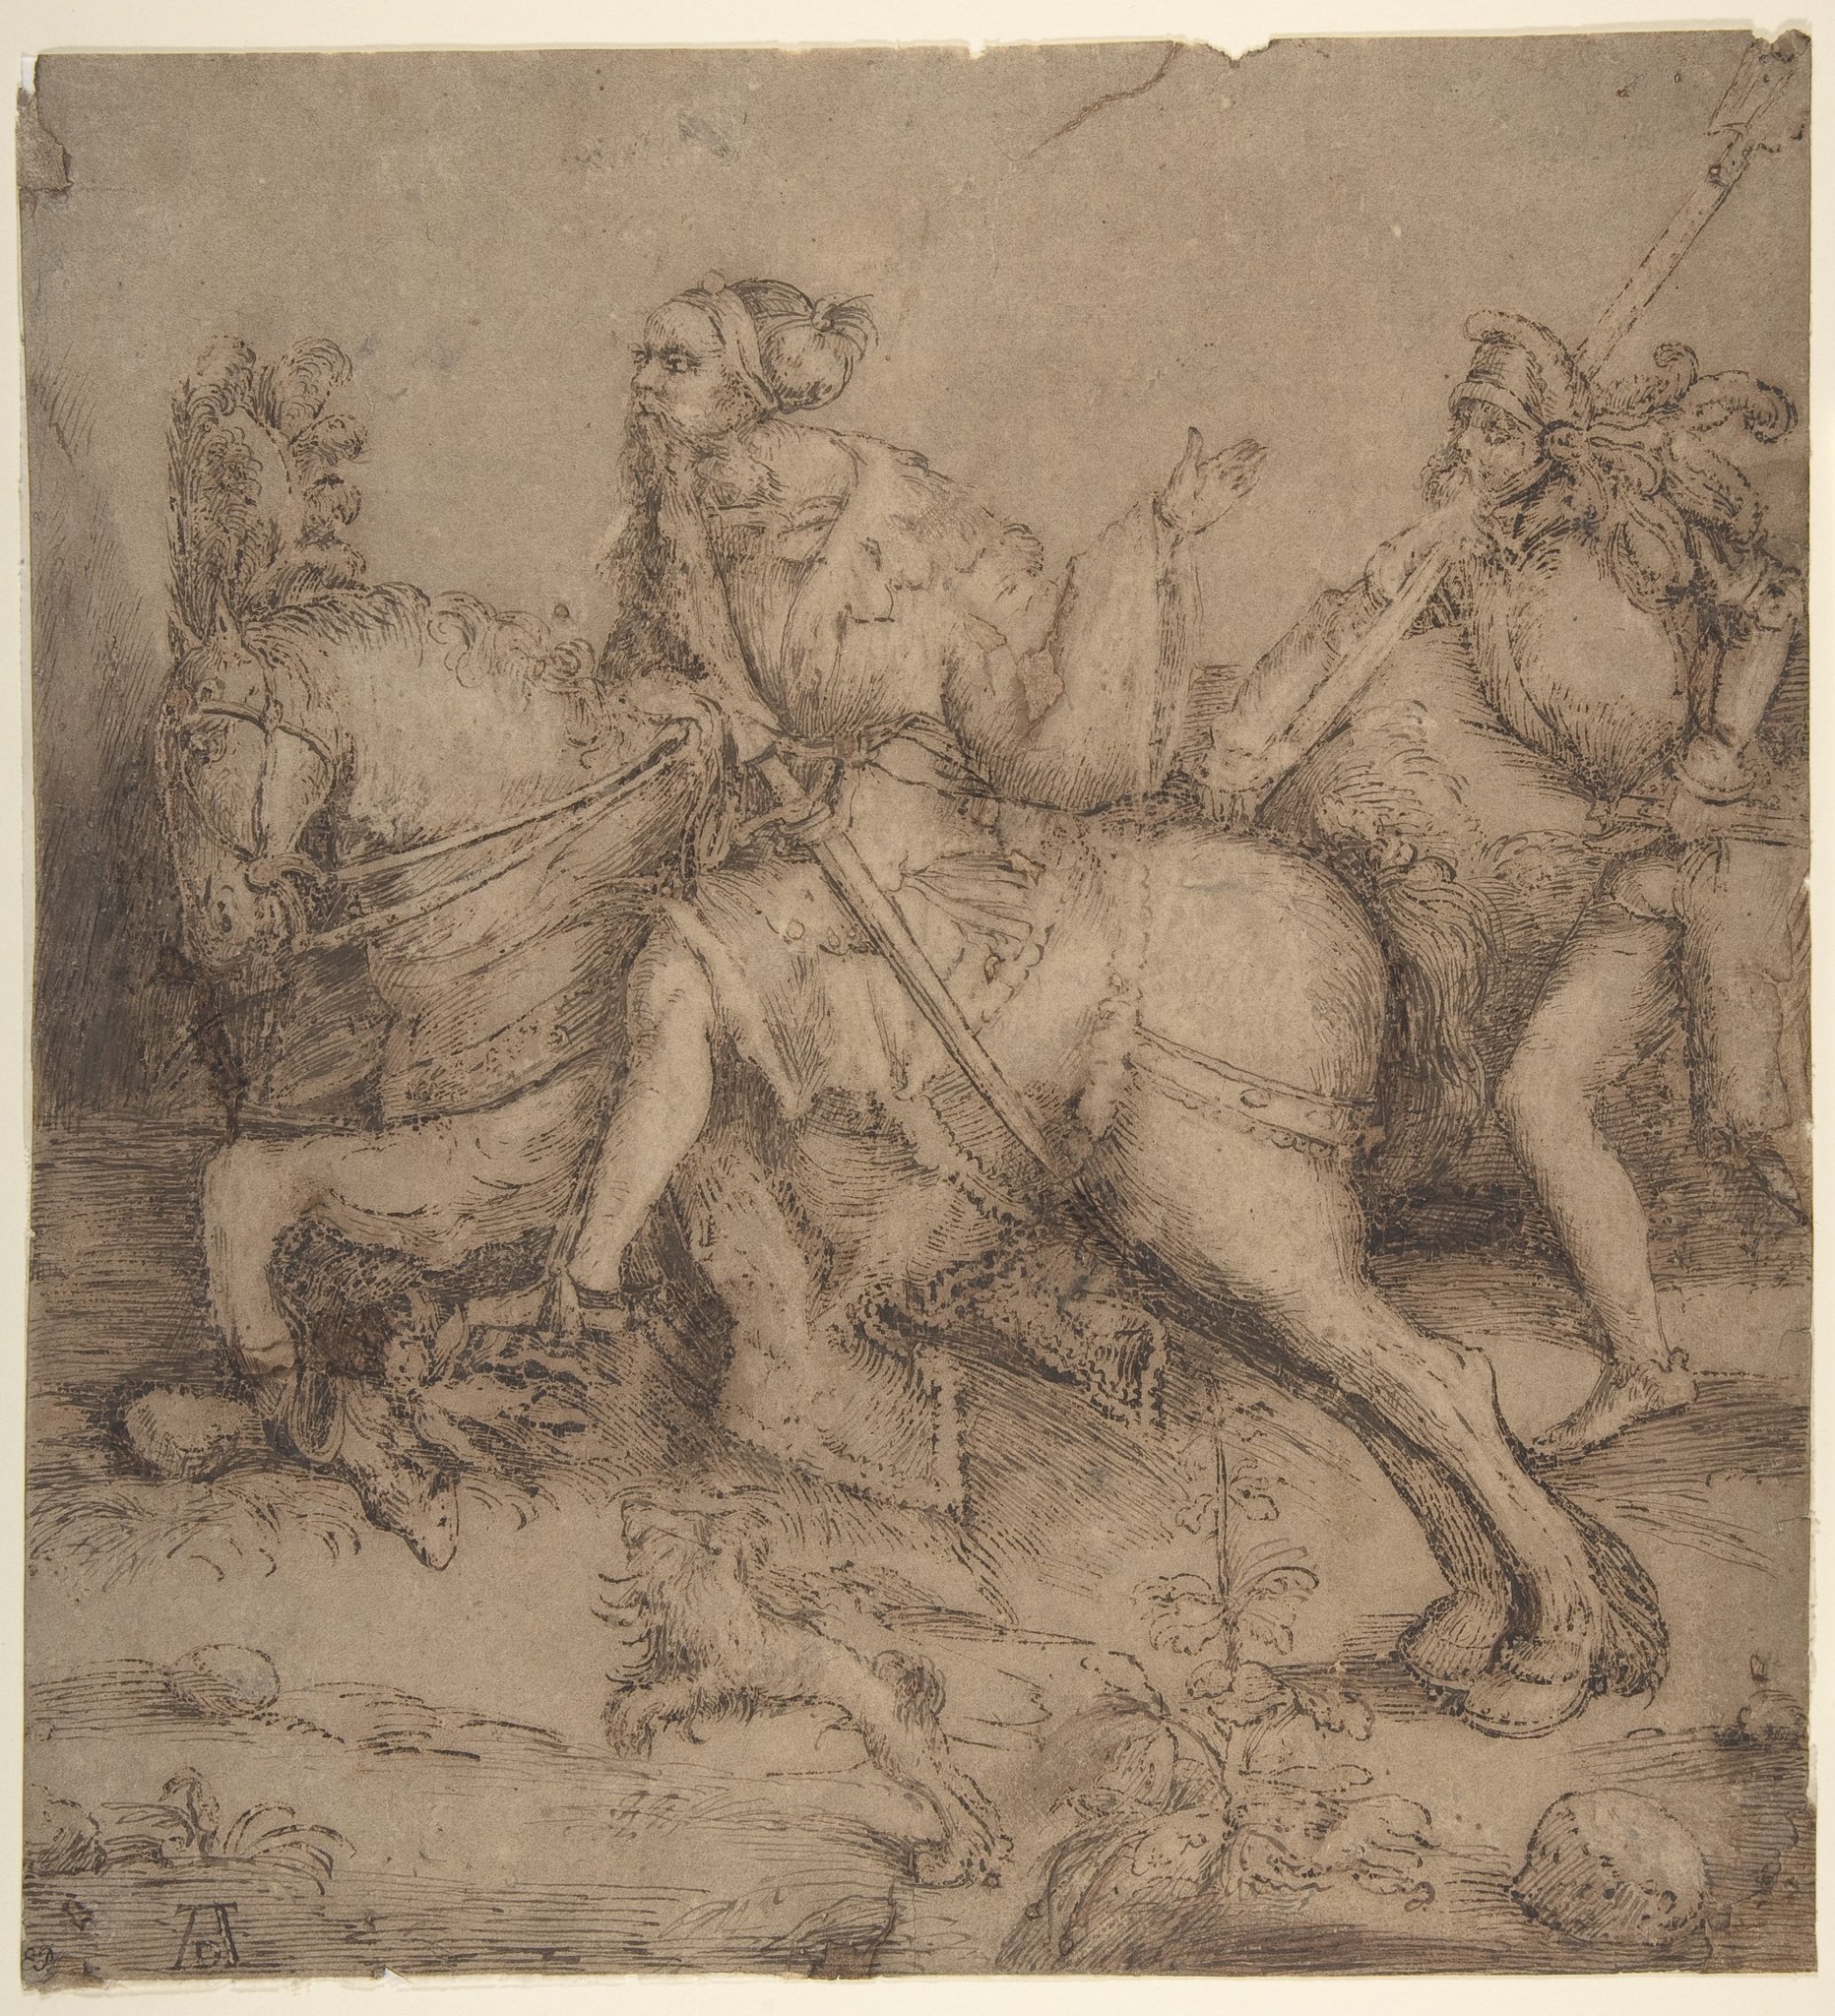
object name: drawing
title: Knight on Horseback and Landsknecht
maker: albrecht dürer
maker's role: artist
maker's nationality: german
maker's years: 1471-1528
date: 1485-1528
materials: down, ink, paper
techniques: brush, pen, wash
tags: men,horses,knights